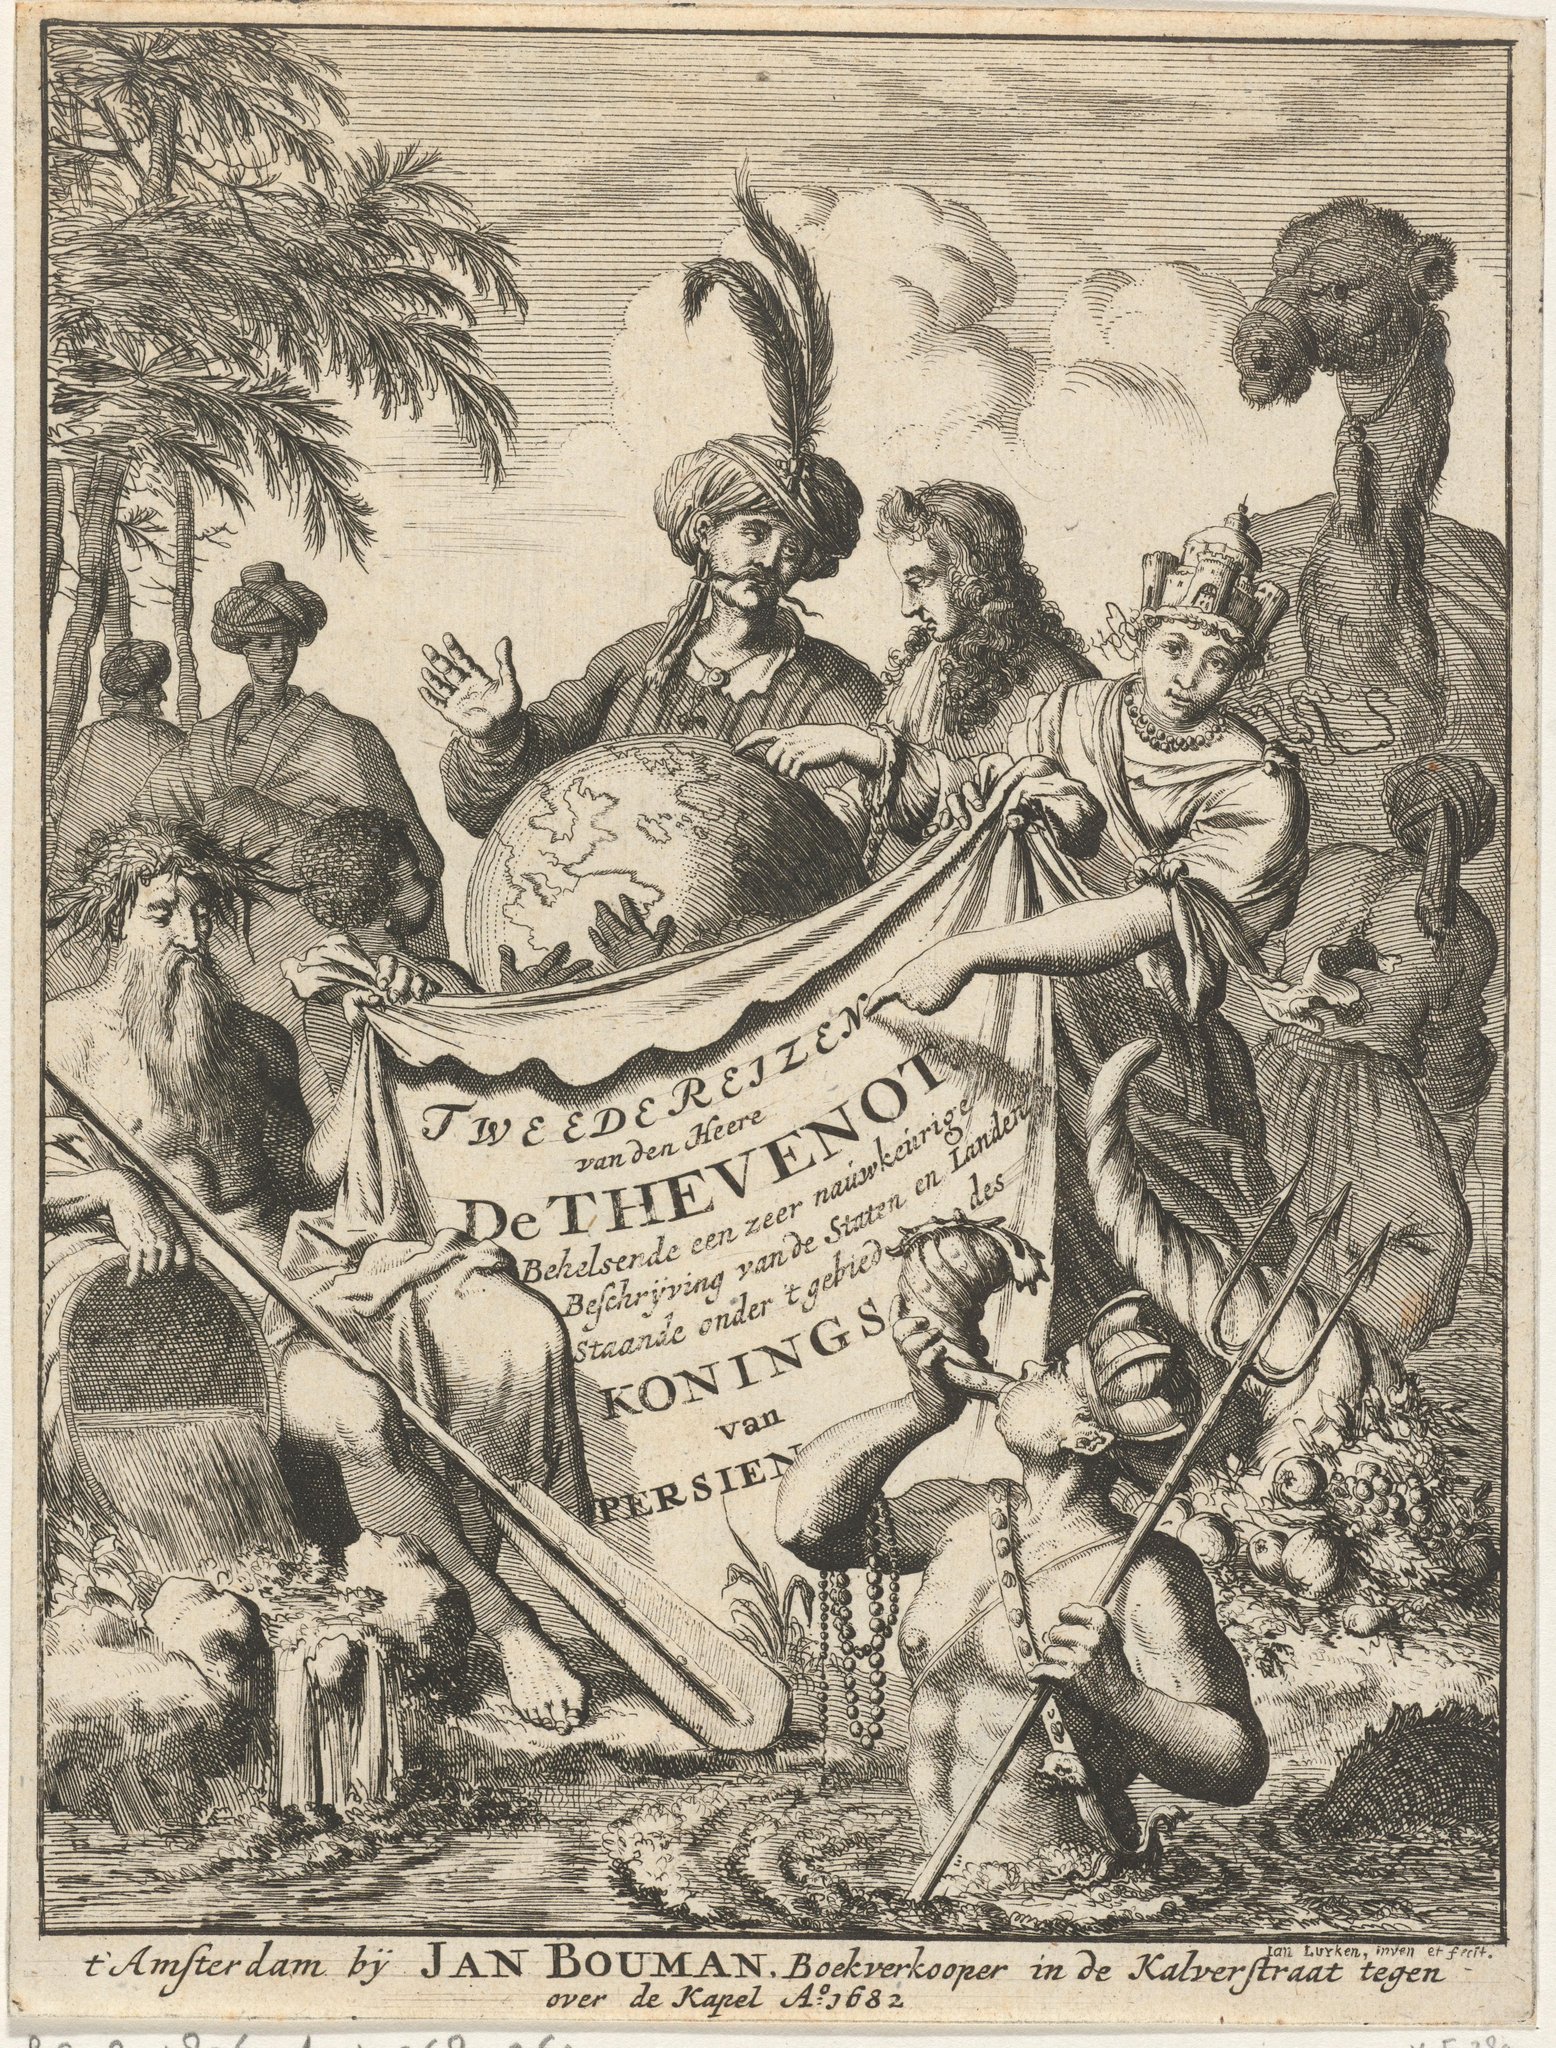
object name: titelblad, titelpagina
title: Jean de Thevenot in gesprek met een Turk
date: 1682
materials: paper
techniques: etching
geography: amsterdam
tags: physicist, jean de thevenot, city-crown, mural crown, asiatic races and peoples: turks, gods of the waters: neptune and his environment, river-gods, globe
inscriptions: collector's mark: Lugt 2228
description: Jean de Thevenot voert een gesprek met een Turk en aanschouwt daarbij een globe. Op de voorgrond houden een vrouwelijke personificatie met muurkroon en een riviergod samen een vellum met de titel van het boek op. In het water hiervoor blaast een zeegod op een schelp.